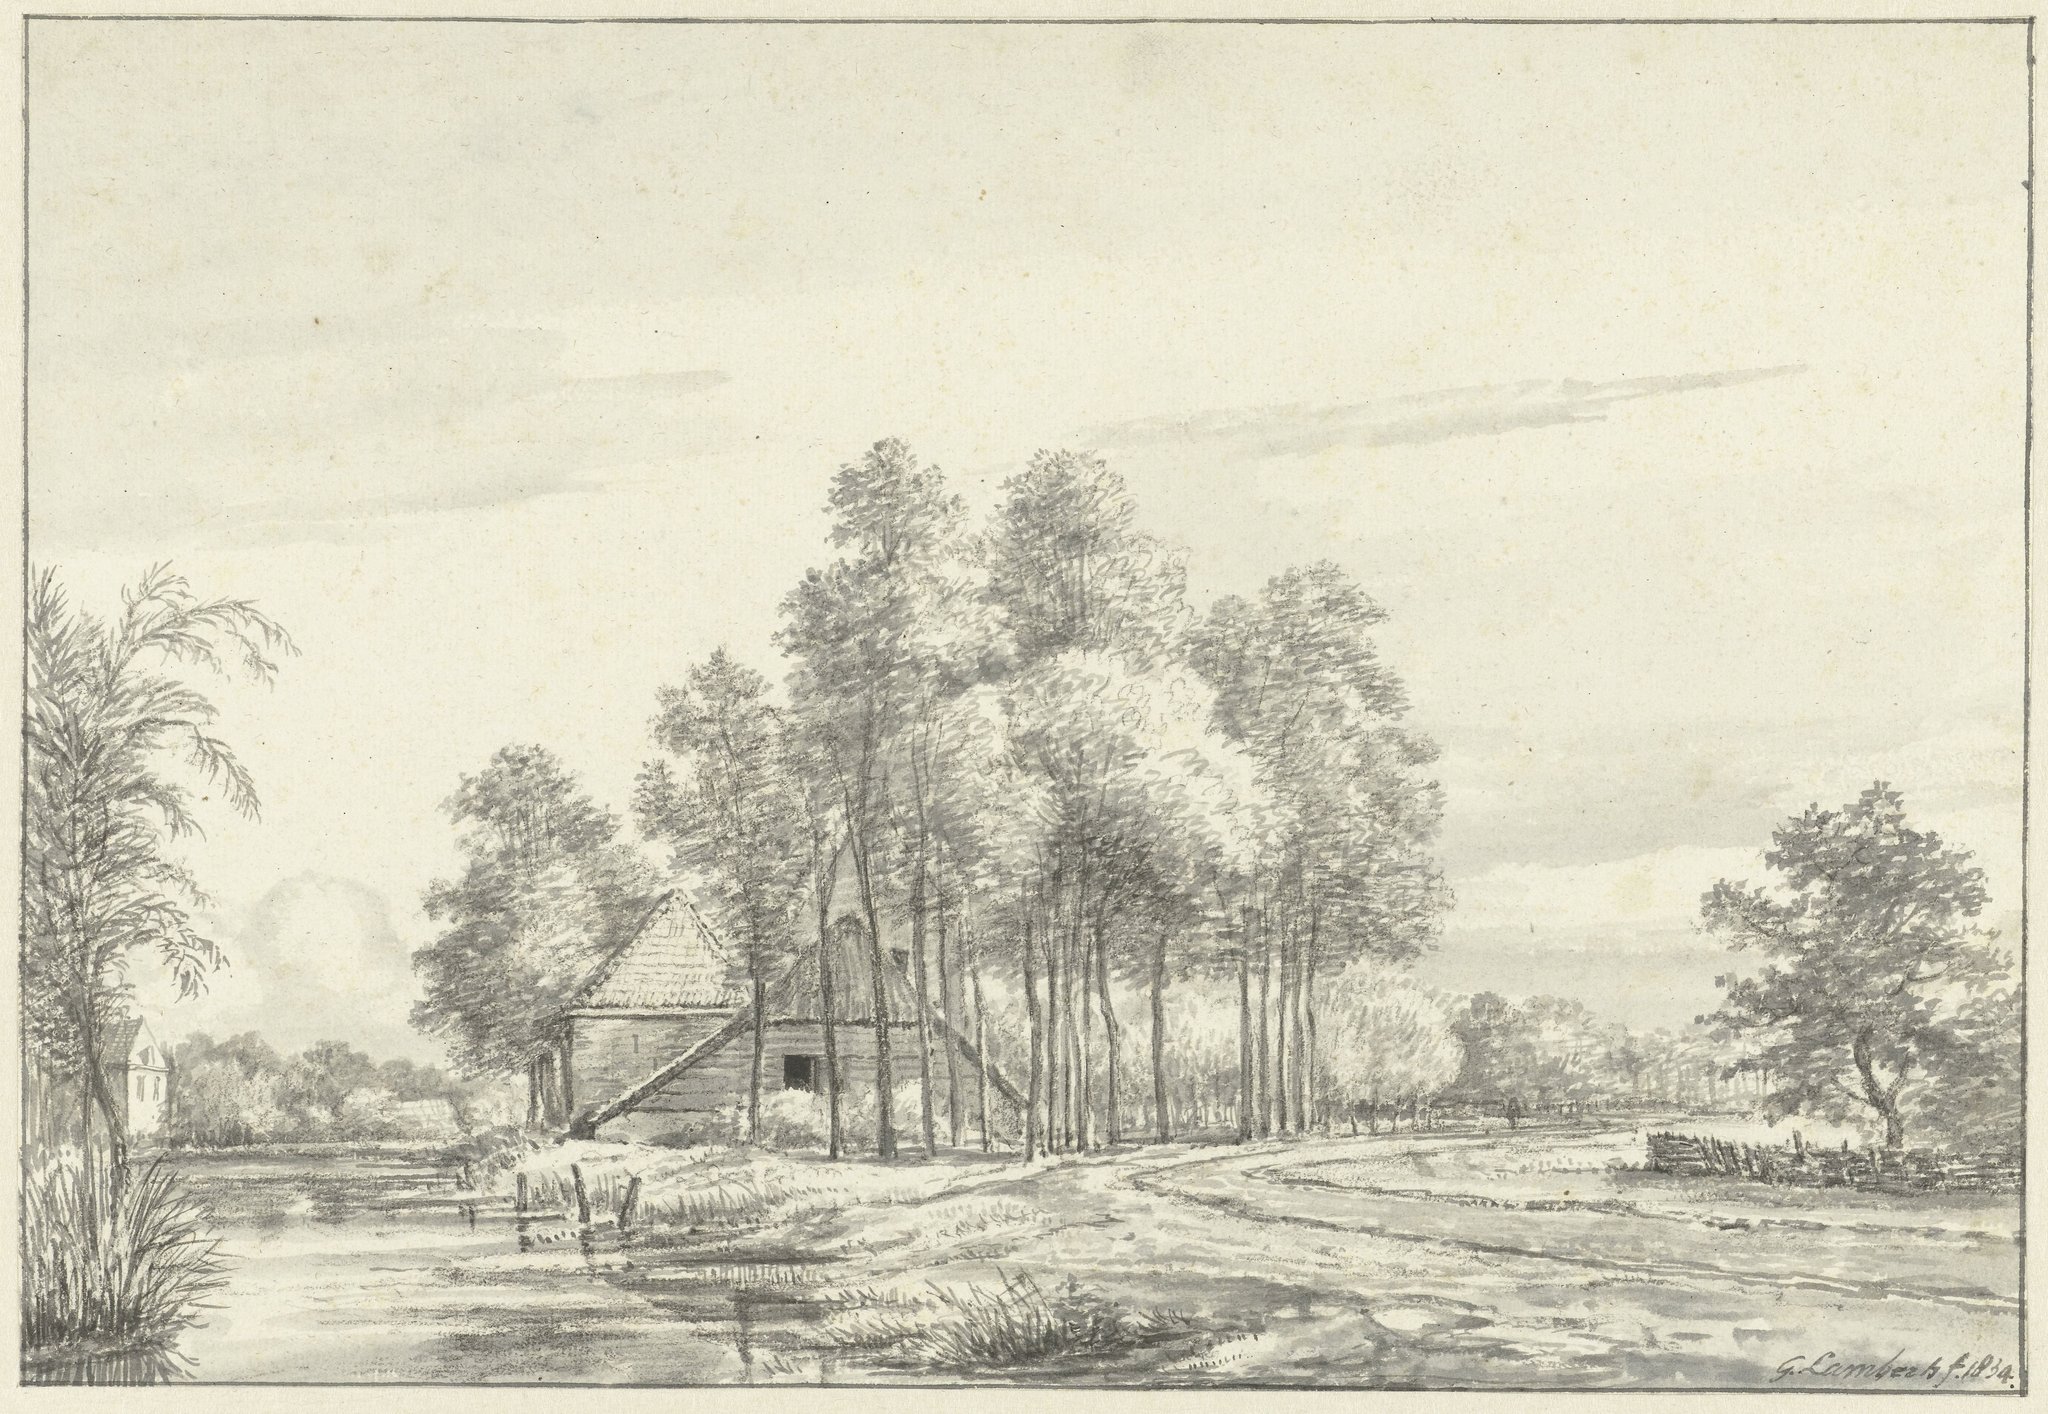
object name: drawing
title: Gezicht bij Oudewater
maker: gerrit lamberts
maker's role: bookseller, draughtsman, print maker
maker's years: 1776-1850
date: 1834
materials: chalk, paper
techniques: brush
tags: city-view, and landscape with man-made constructions